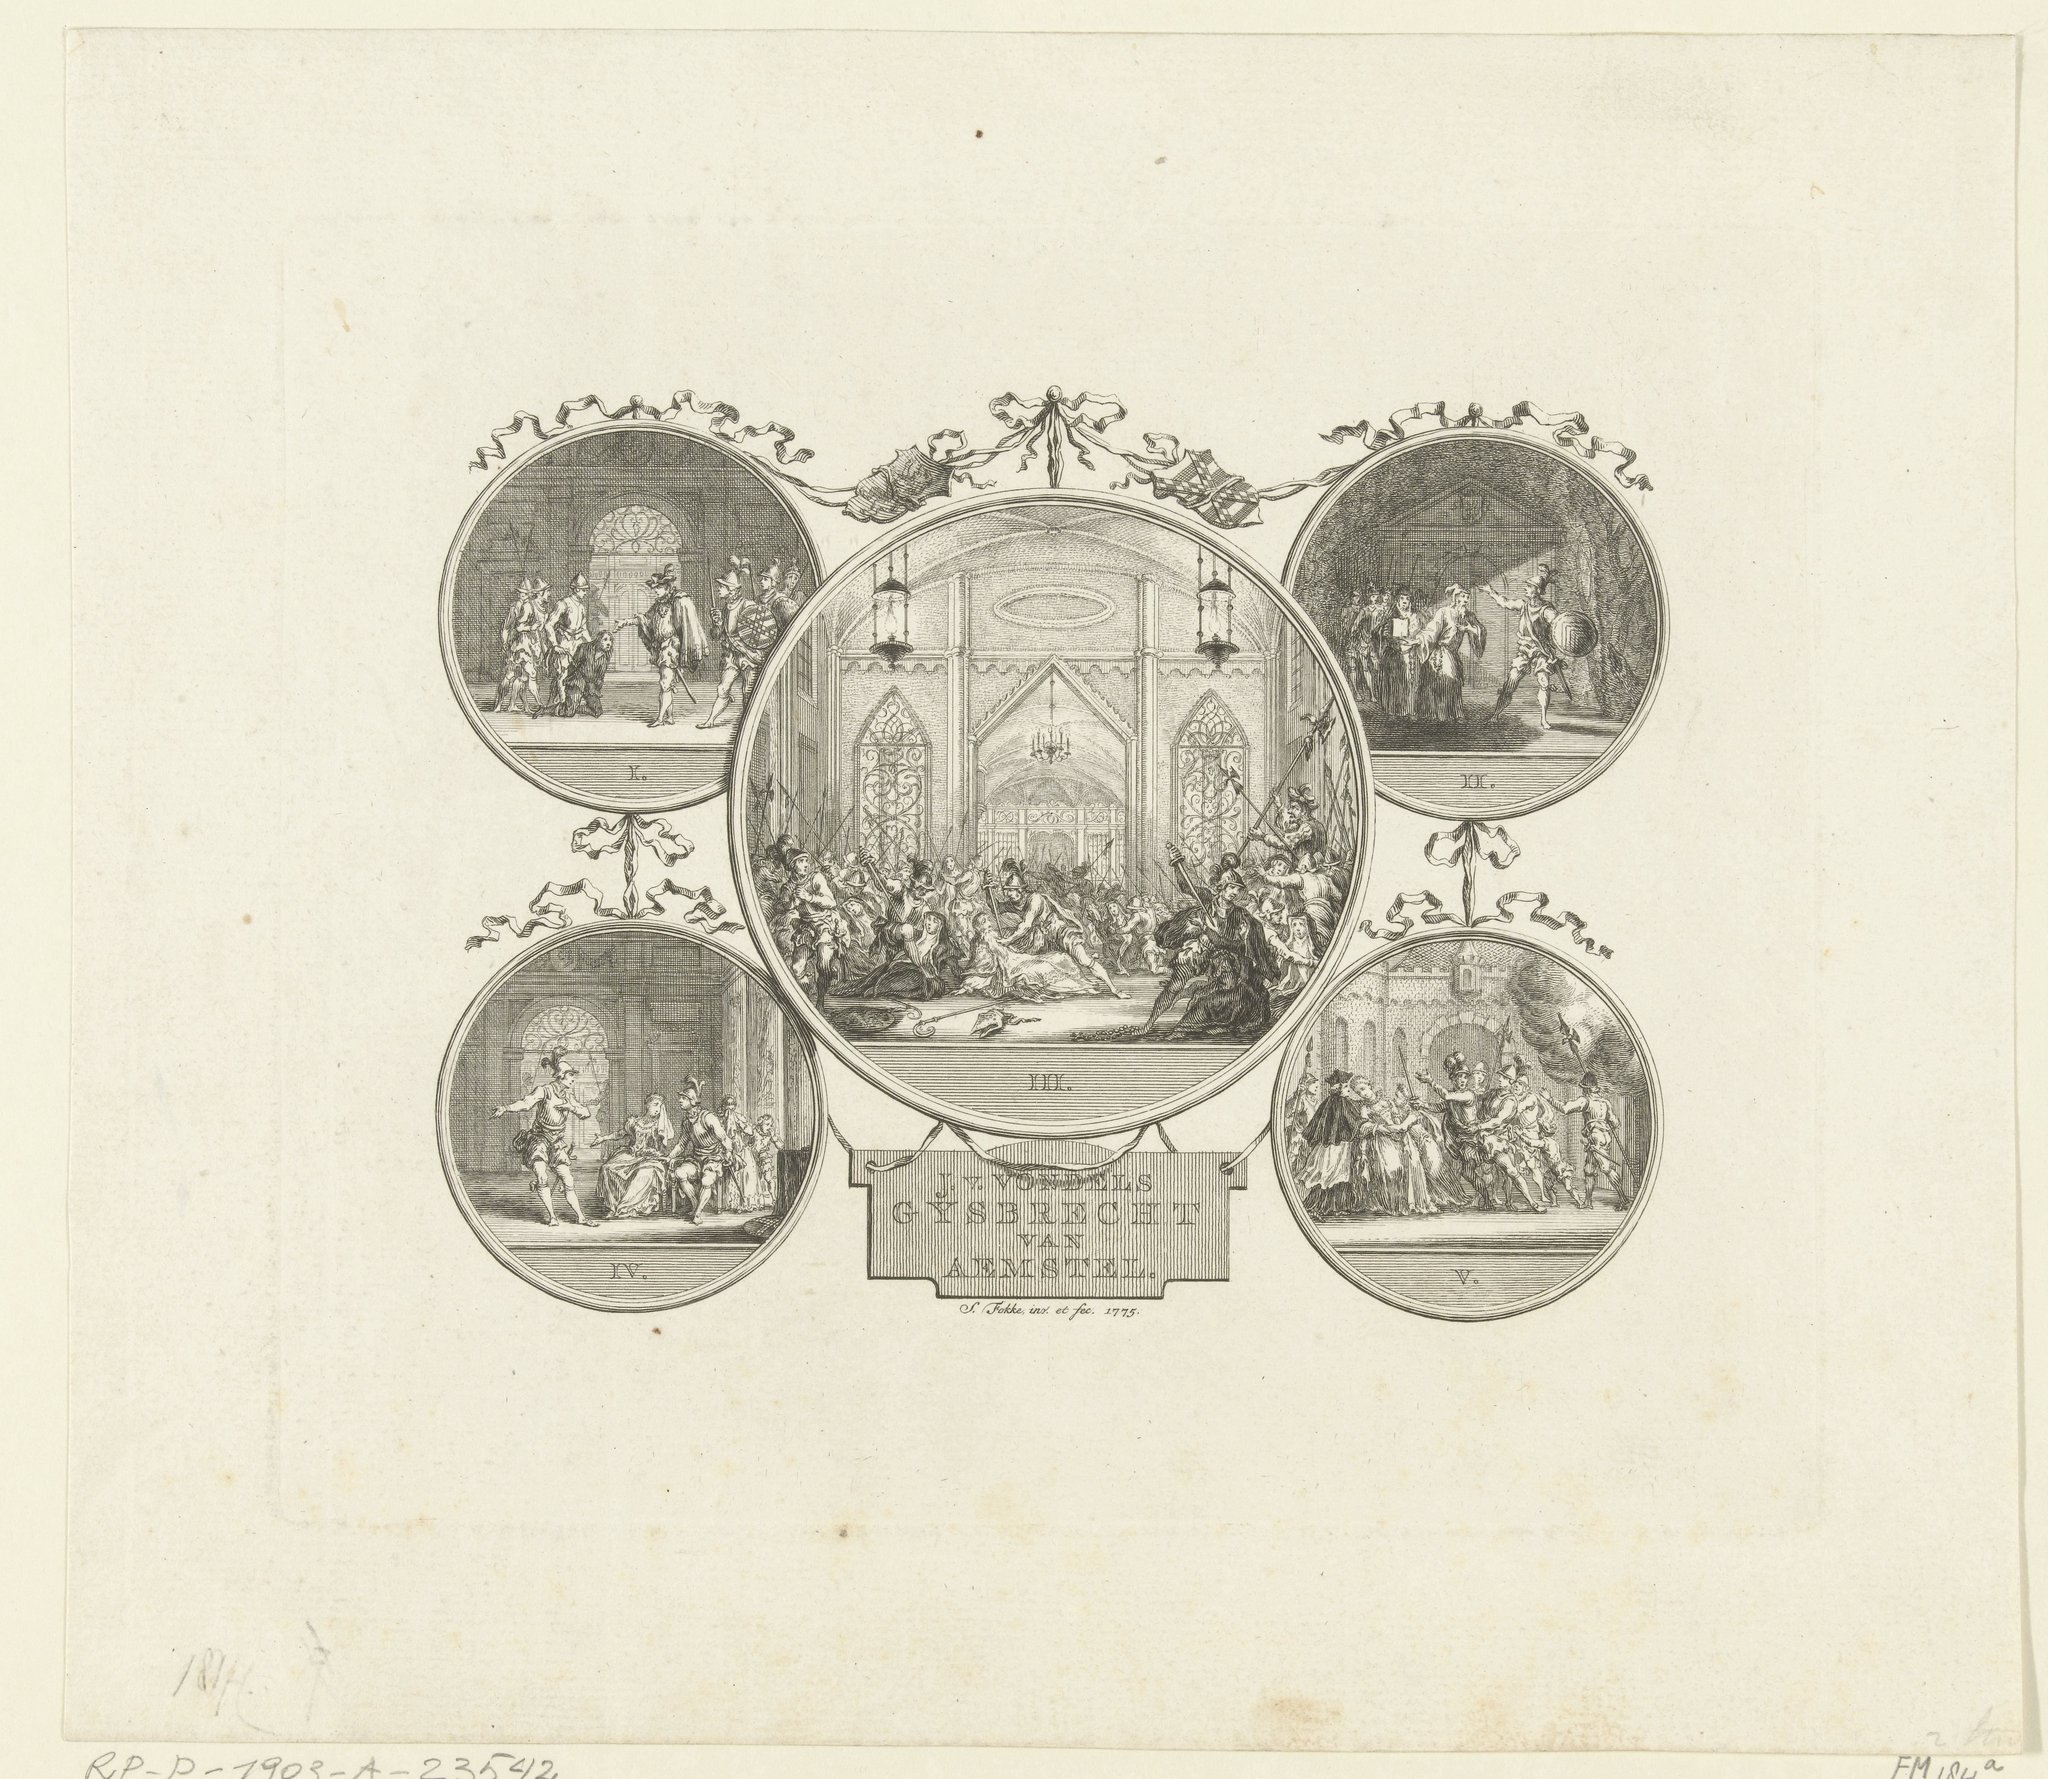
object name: print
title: Blad met vijf scènes uit Vondels Gijsbrecht van Amstel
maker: simon fokke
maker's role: draughtsman, print maker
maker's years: 1712-1784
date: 1775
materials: paper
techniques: etching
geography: northern netherlands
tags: cologne, amsterdam, joost van den vondel, theatre, theatrical performance, netherlands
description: Blad met vijf toneelscènes in ronde medaillons genummerd I-V uit het toneelstuk Gijsbrecht van Amstel van Joost van den Vondel. Centraal een grote ronde voorstelling omringd door vier kleine ronden. De medaillons verbonden door linten, onderaan een cartouche met de tekst: J.v.Vondels Gysbrecht van Aemstel.